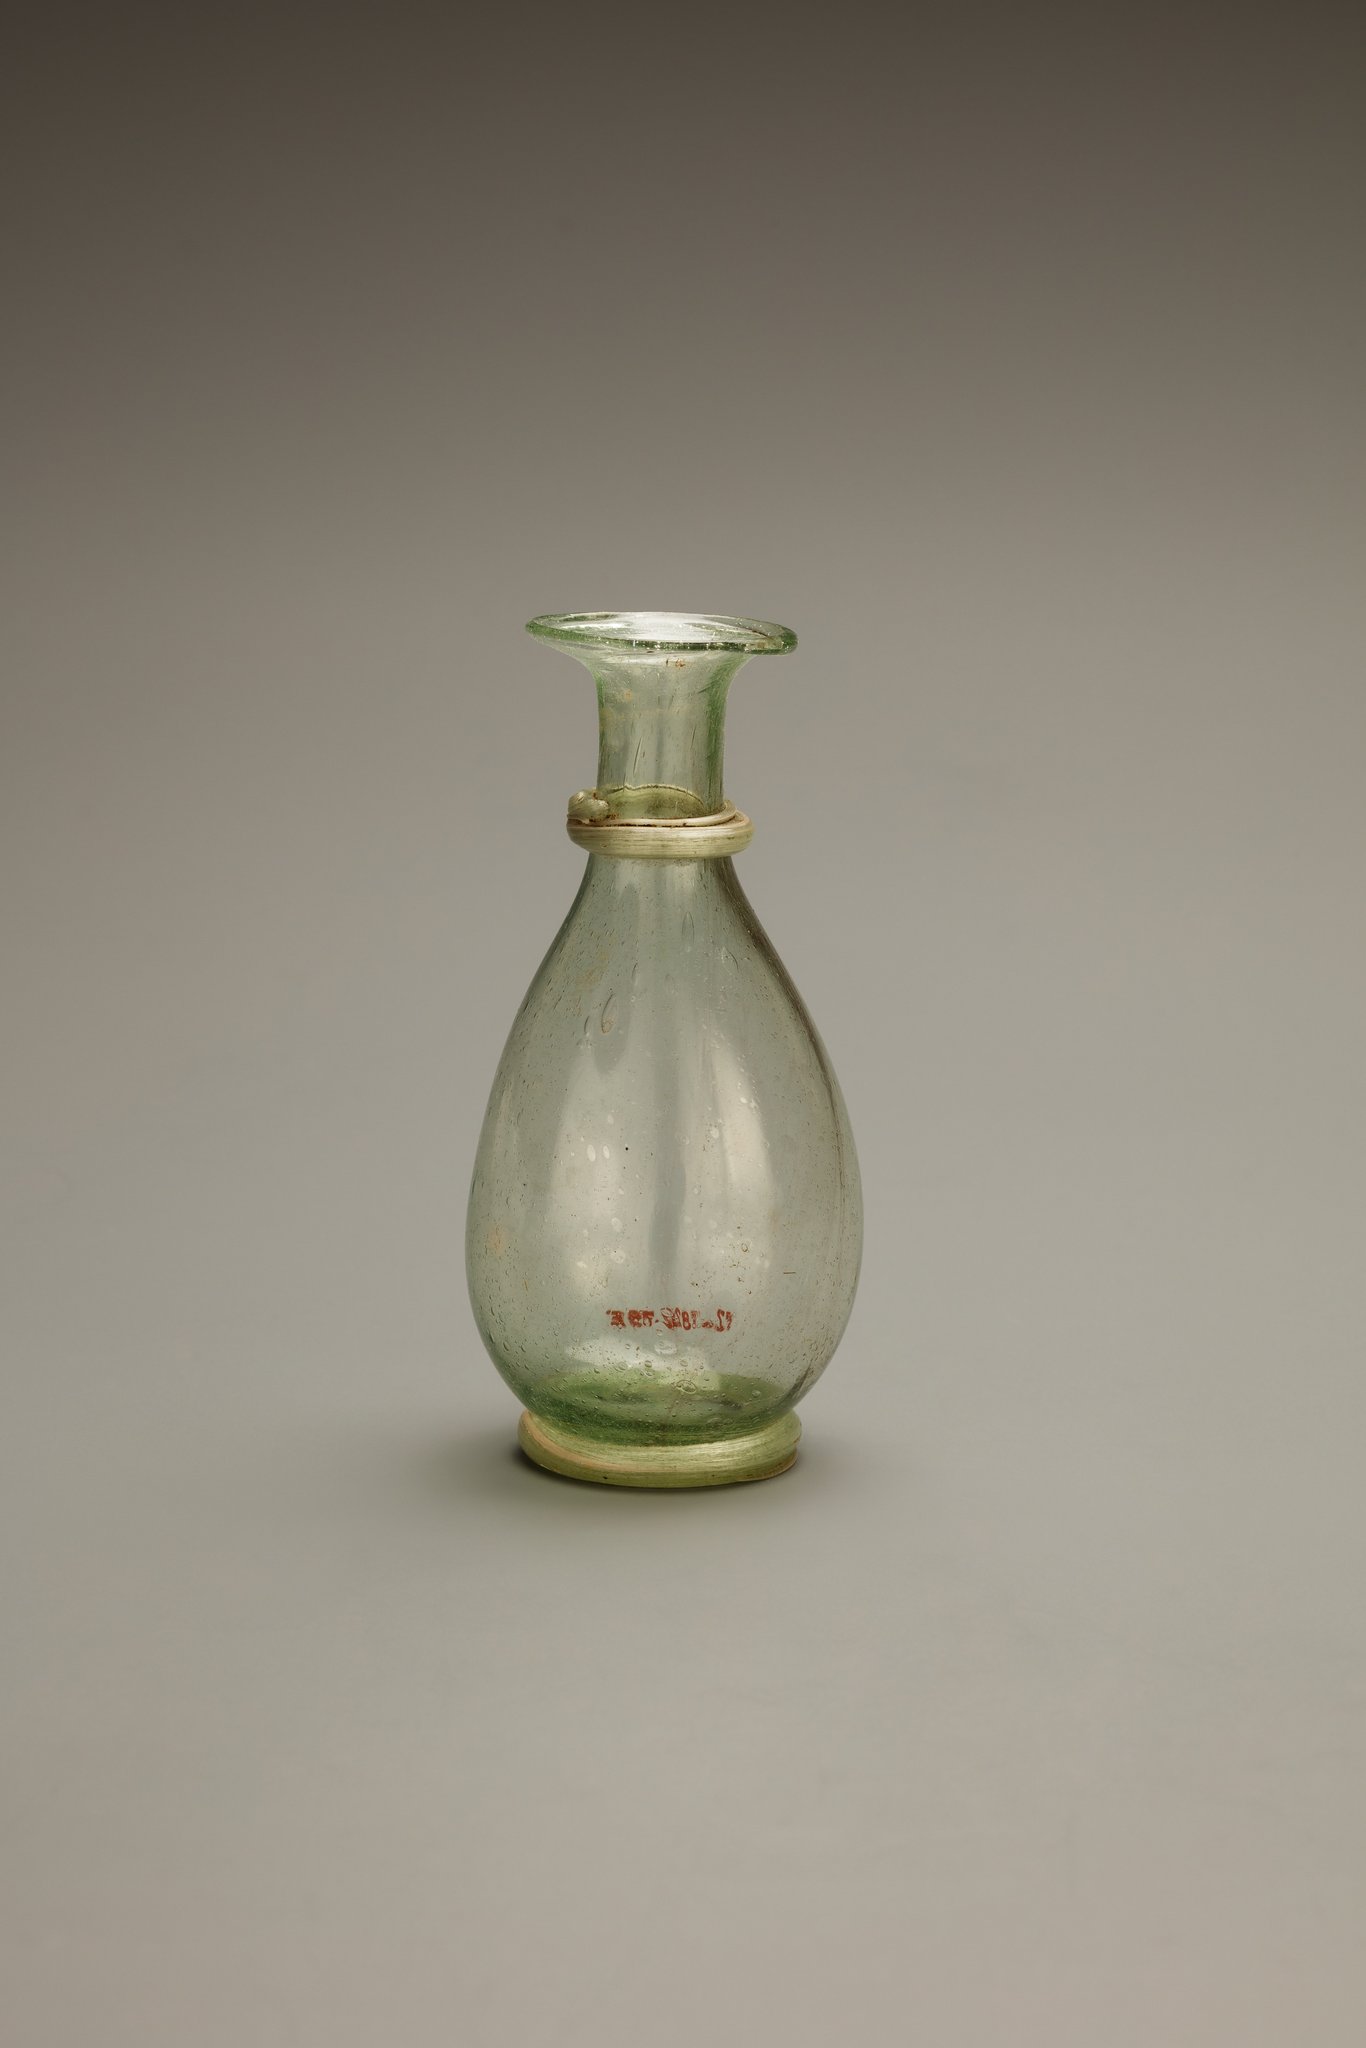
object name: bottle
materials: glass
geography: middle egypt